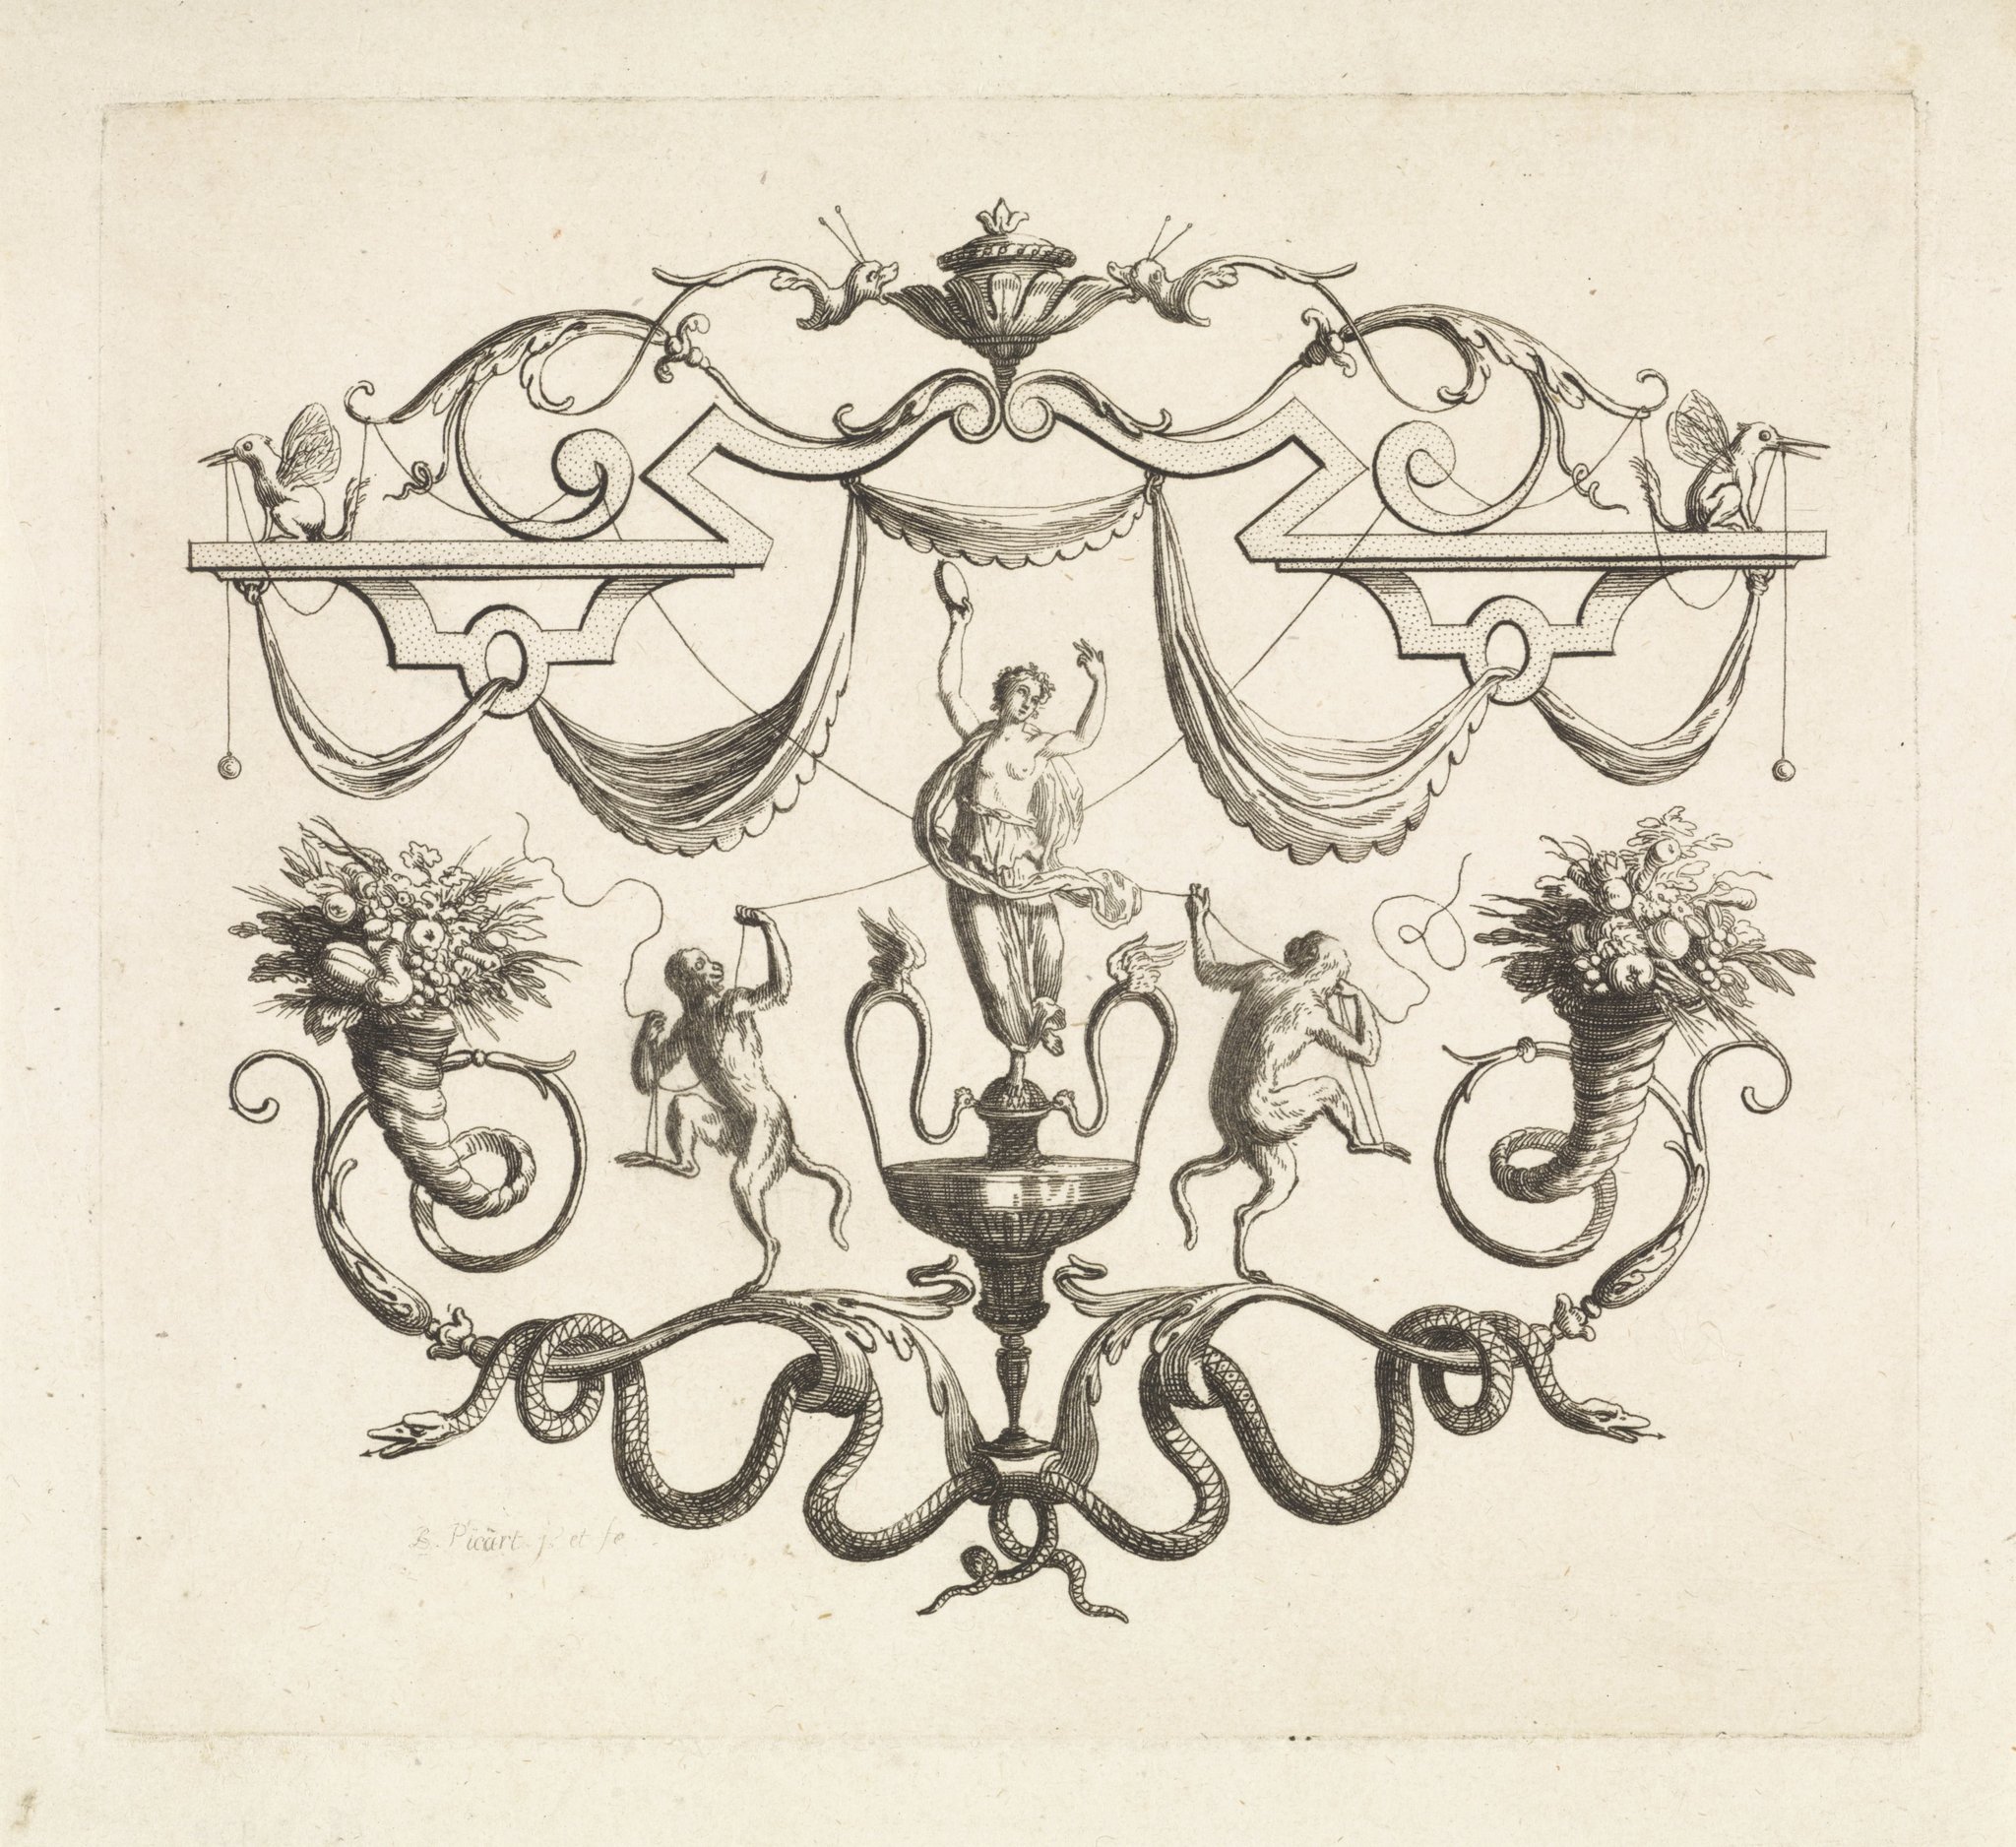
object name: print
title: Ornament met een maenade met tamboerijn en twee aapjes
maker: bernard picart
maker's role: draughtsman, print maker, publisher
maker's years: 1673-1733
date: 1683-1733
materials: paper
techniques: engraving, etching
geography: amsterdam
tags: ornaments ~ art, ornament derived from animal forms, dancing, fabulous animals ~ monkeys, maenad(s), female bacchant(es)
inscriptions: collector's mark: Lugt 2228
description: Ornament met centraal een dansende maenade met een tamboerijn in de hand. Aan weerszijden apen en hoornen des overvloeds.